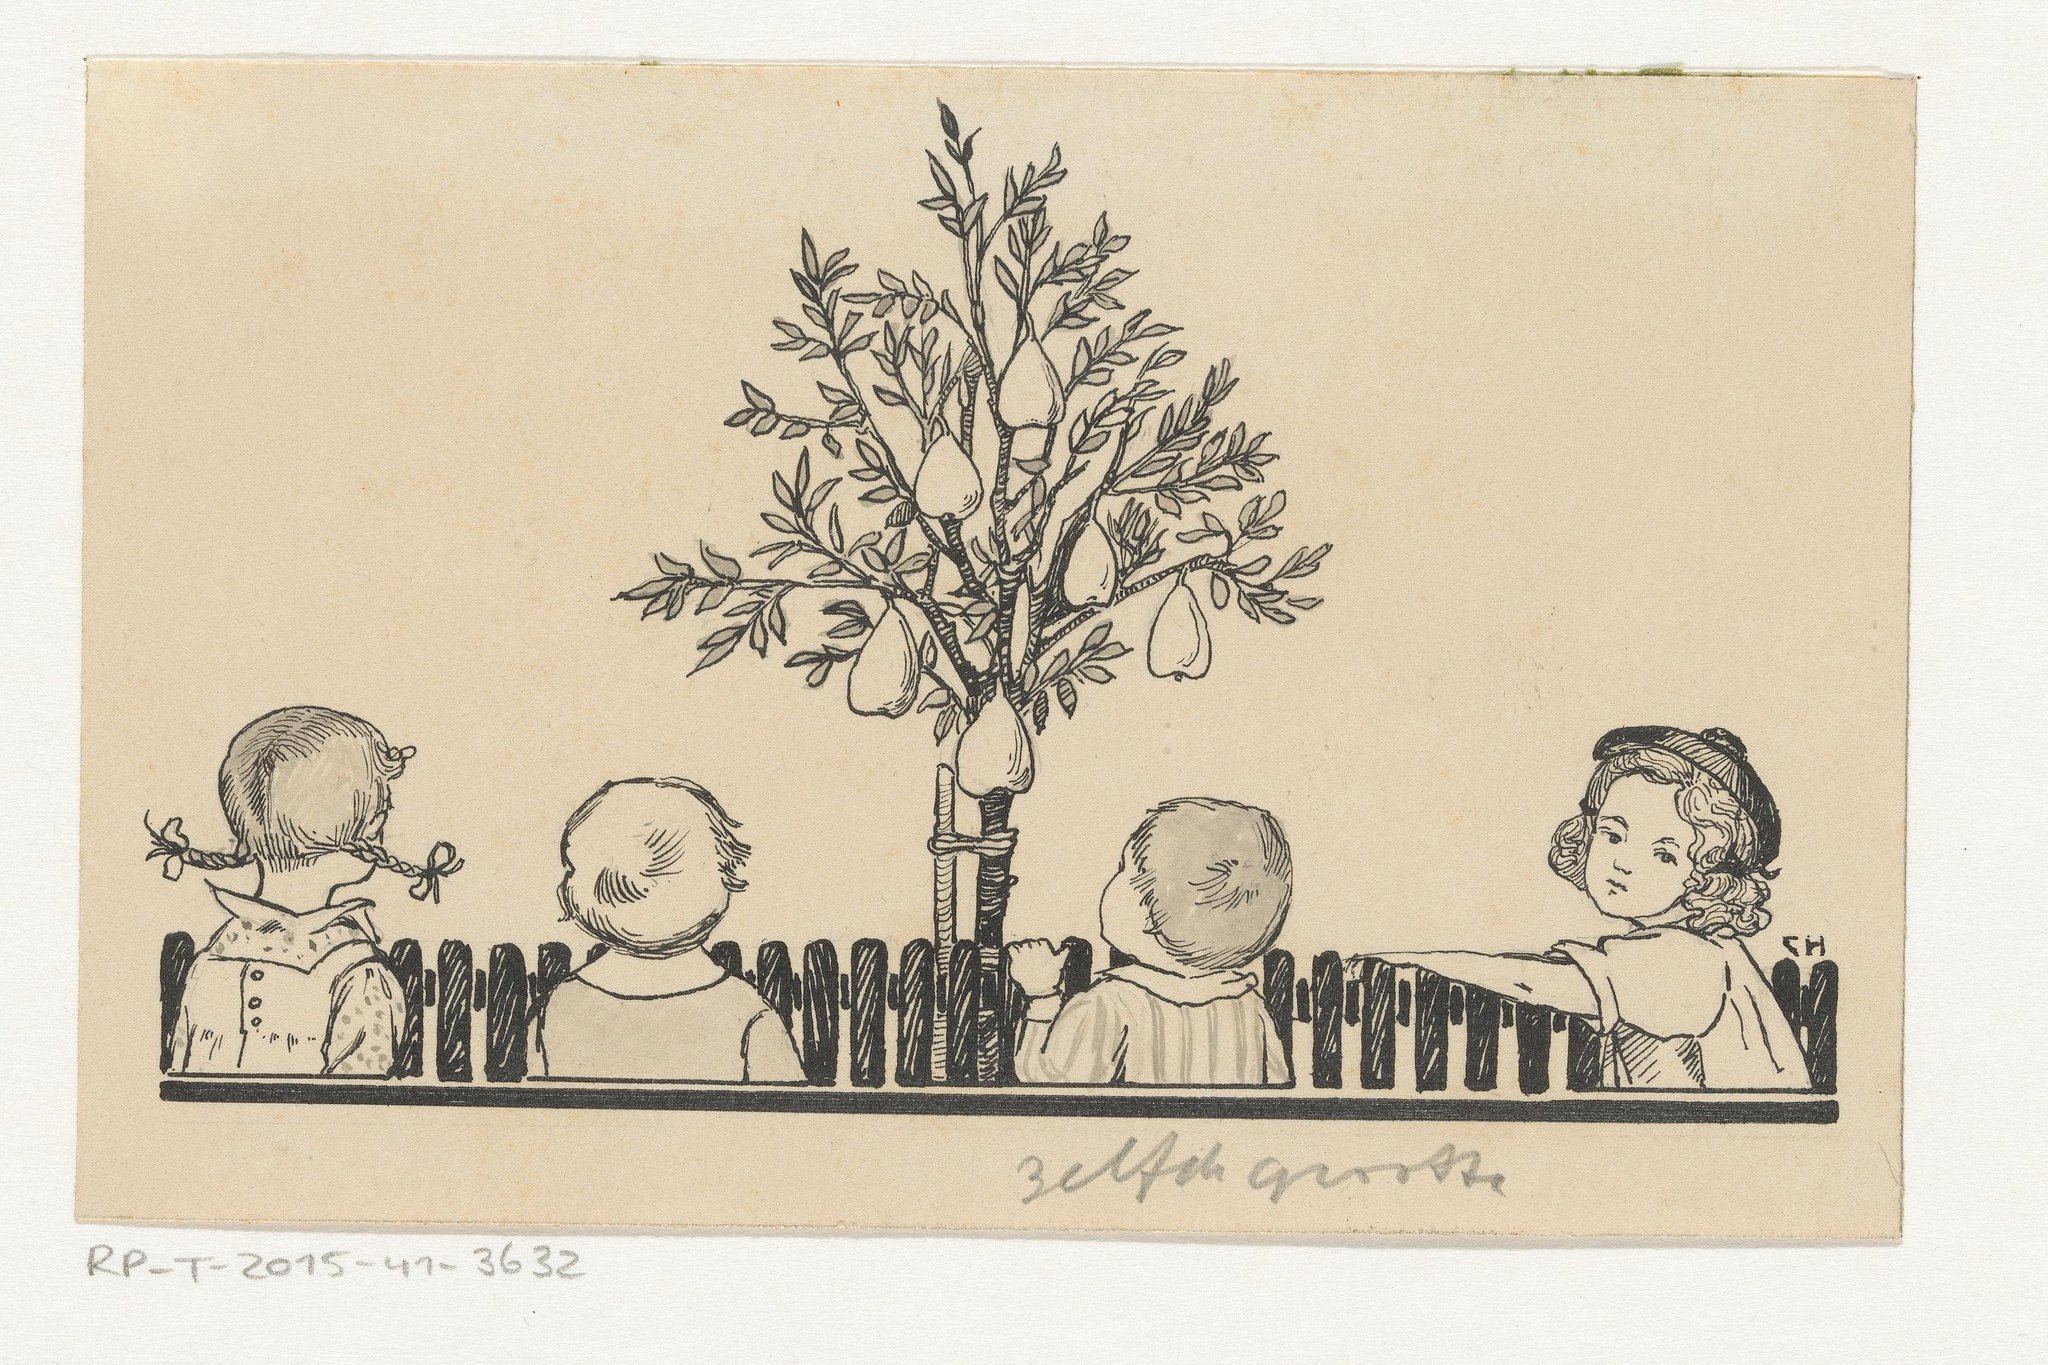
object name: drawing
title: Vier kinderen bij een perenboom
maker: Anonymous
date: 1890-1940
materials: ink, paper, pencil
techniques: brush, pen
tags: 25g3(pear-tree), fence, wall, paling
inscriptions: signature: ‘CH’, :, collector's mark: Lugt 2228a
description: Twee jongens en twee meisjes kijken van achter een hek naar een perenboom.